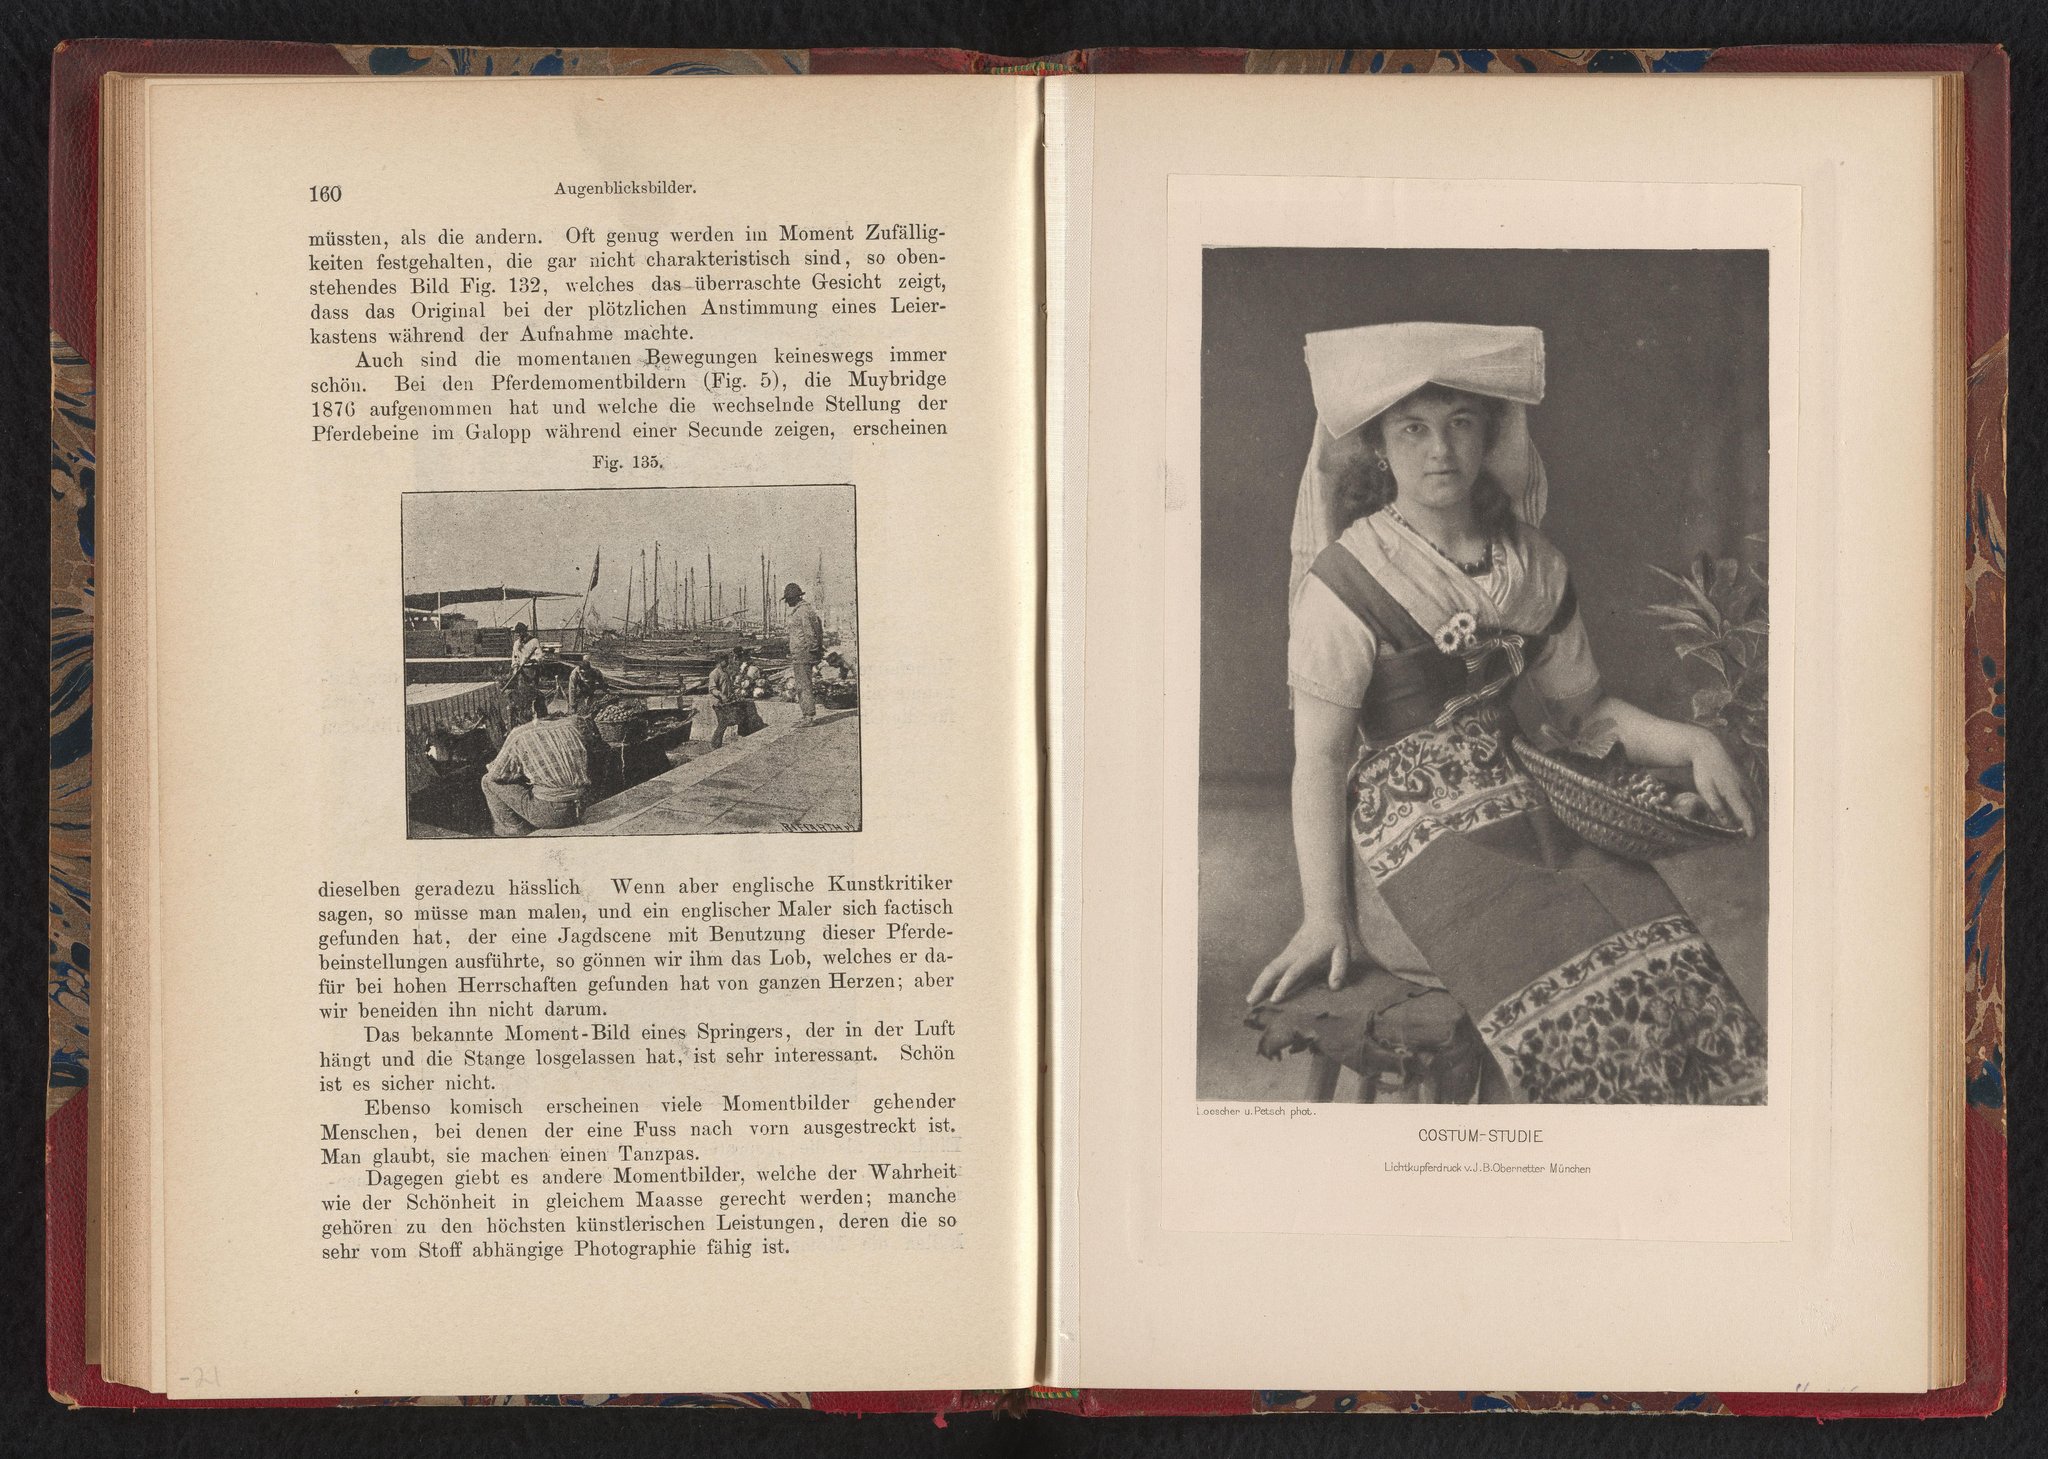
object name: photomechanical print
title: Portret van een onbekende vrouw in klederdracht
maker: johann baptist obernetter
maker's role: printer, publisher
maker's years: 1840-1887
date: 1886-1891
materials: paper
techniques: photograph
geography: munich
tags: folk costume, regional costume, anonymous historical person portrayed - bb - woman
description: Prent op ongenummerde pagina tegenover pagina 160.